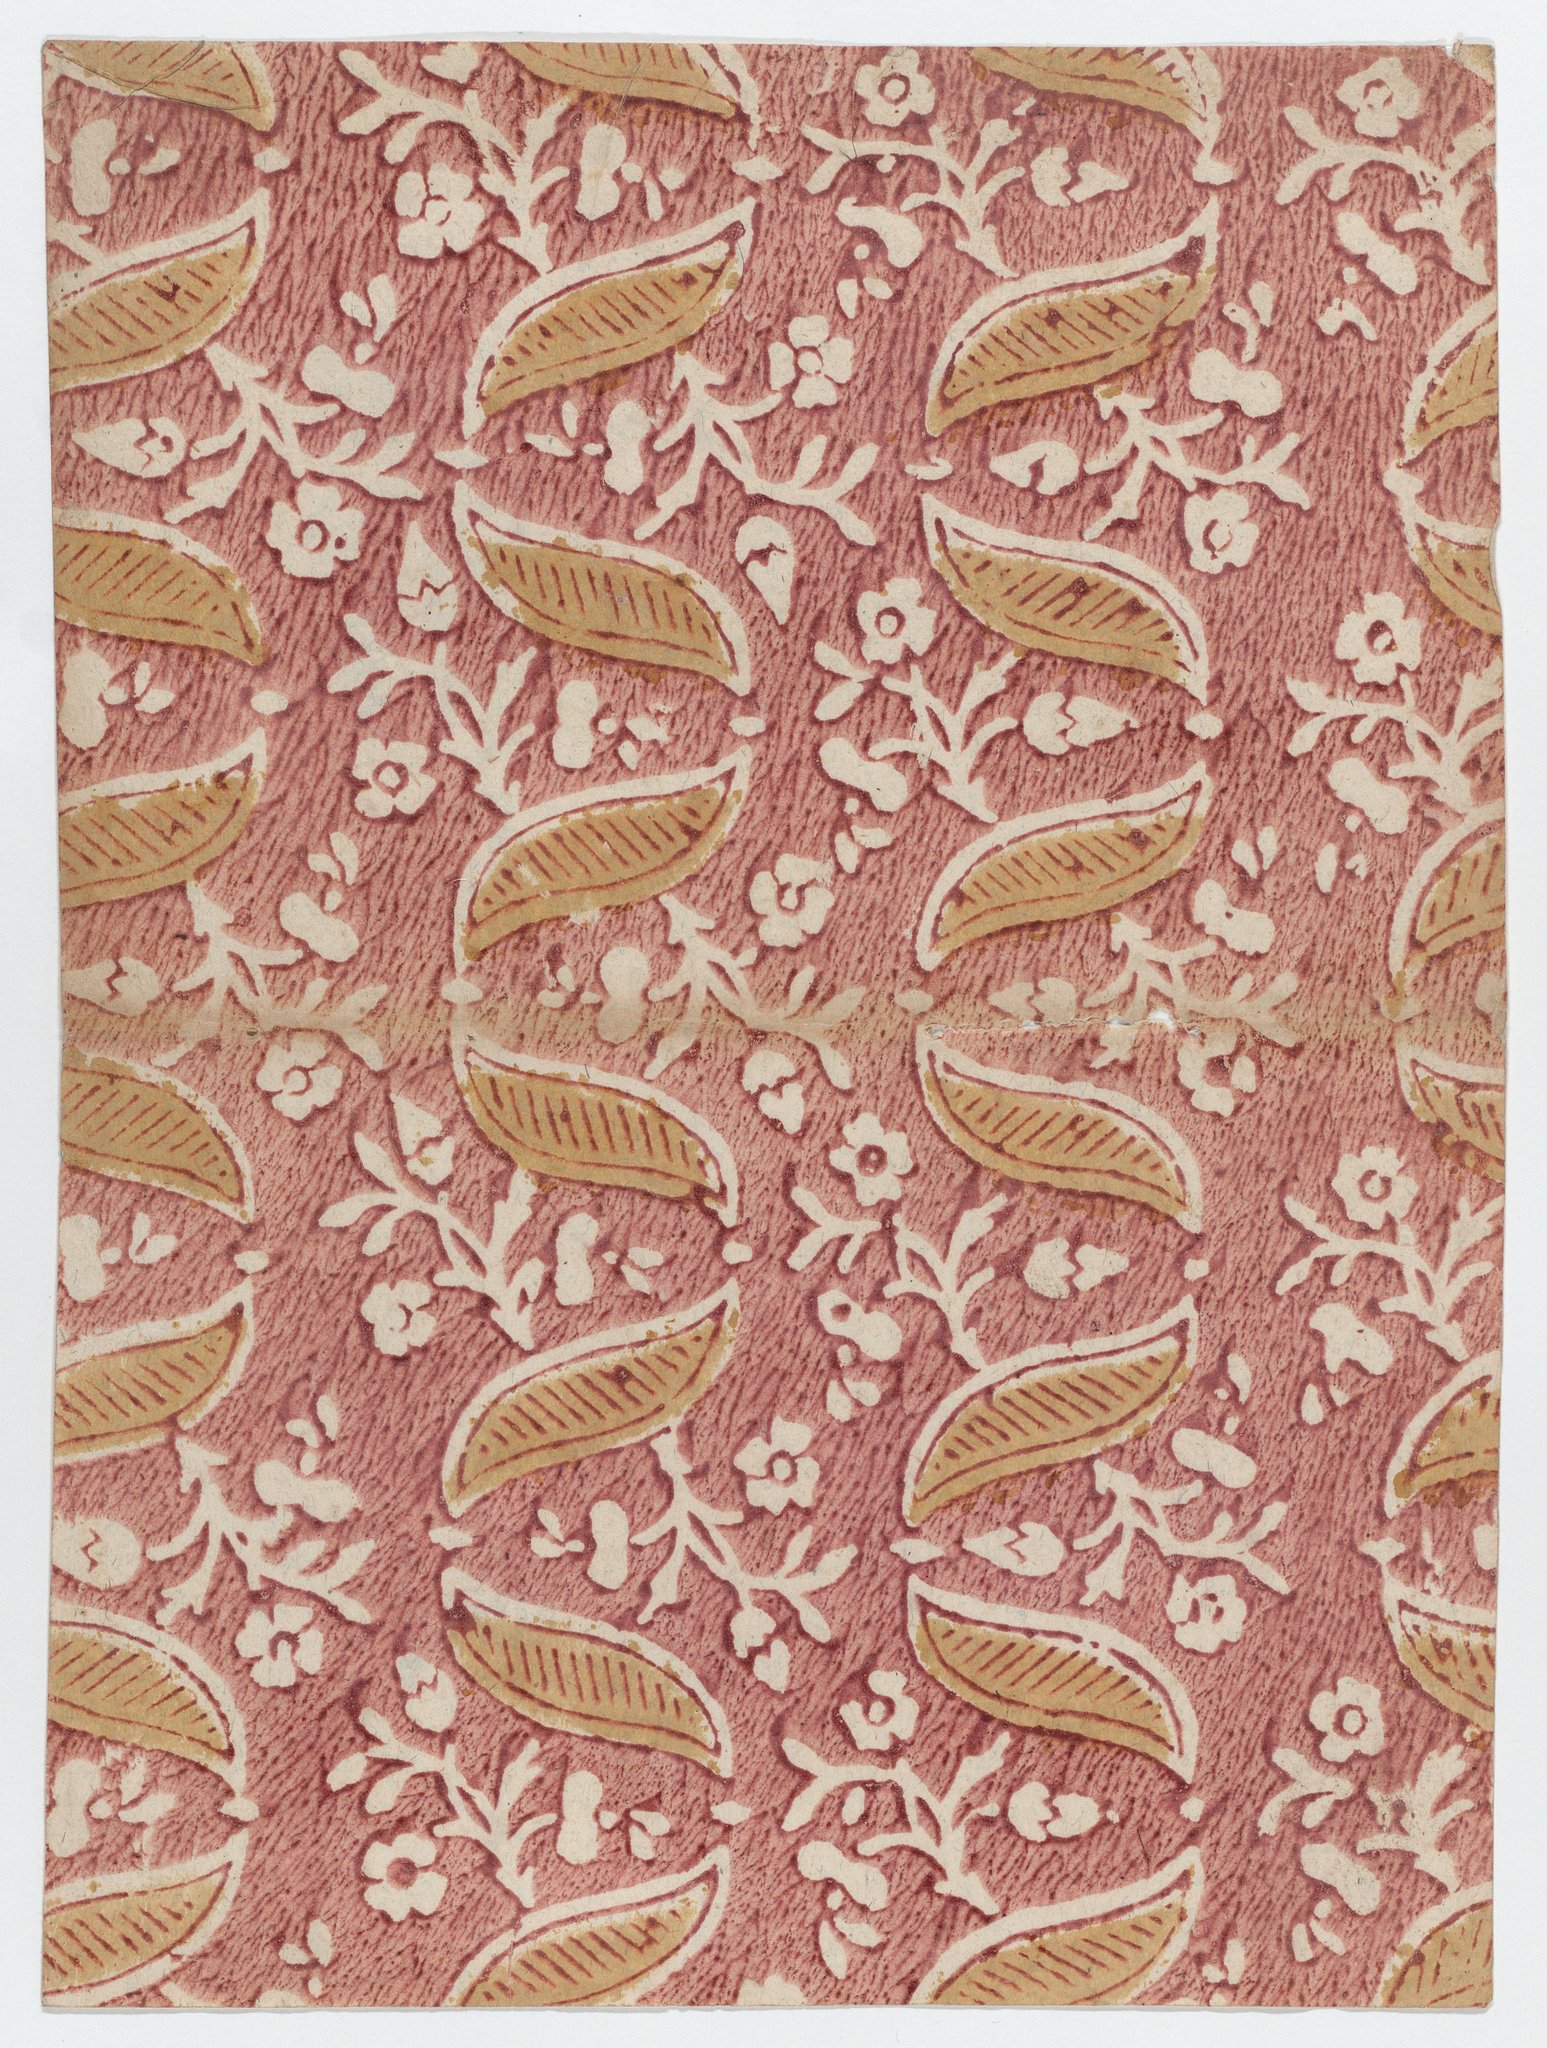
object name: print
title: Book cover with overall red floral pattern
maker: Anonymous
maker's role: artist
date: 1701-1800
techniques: relief print